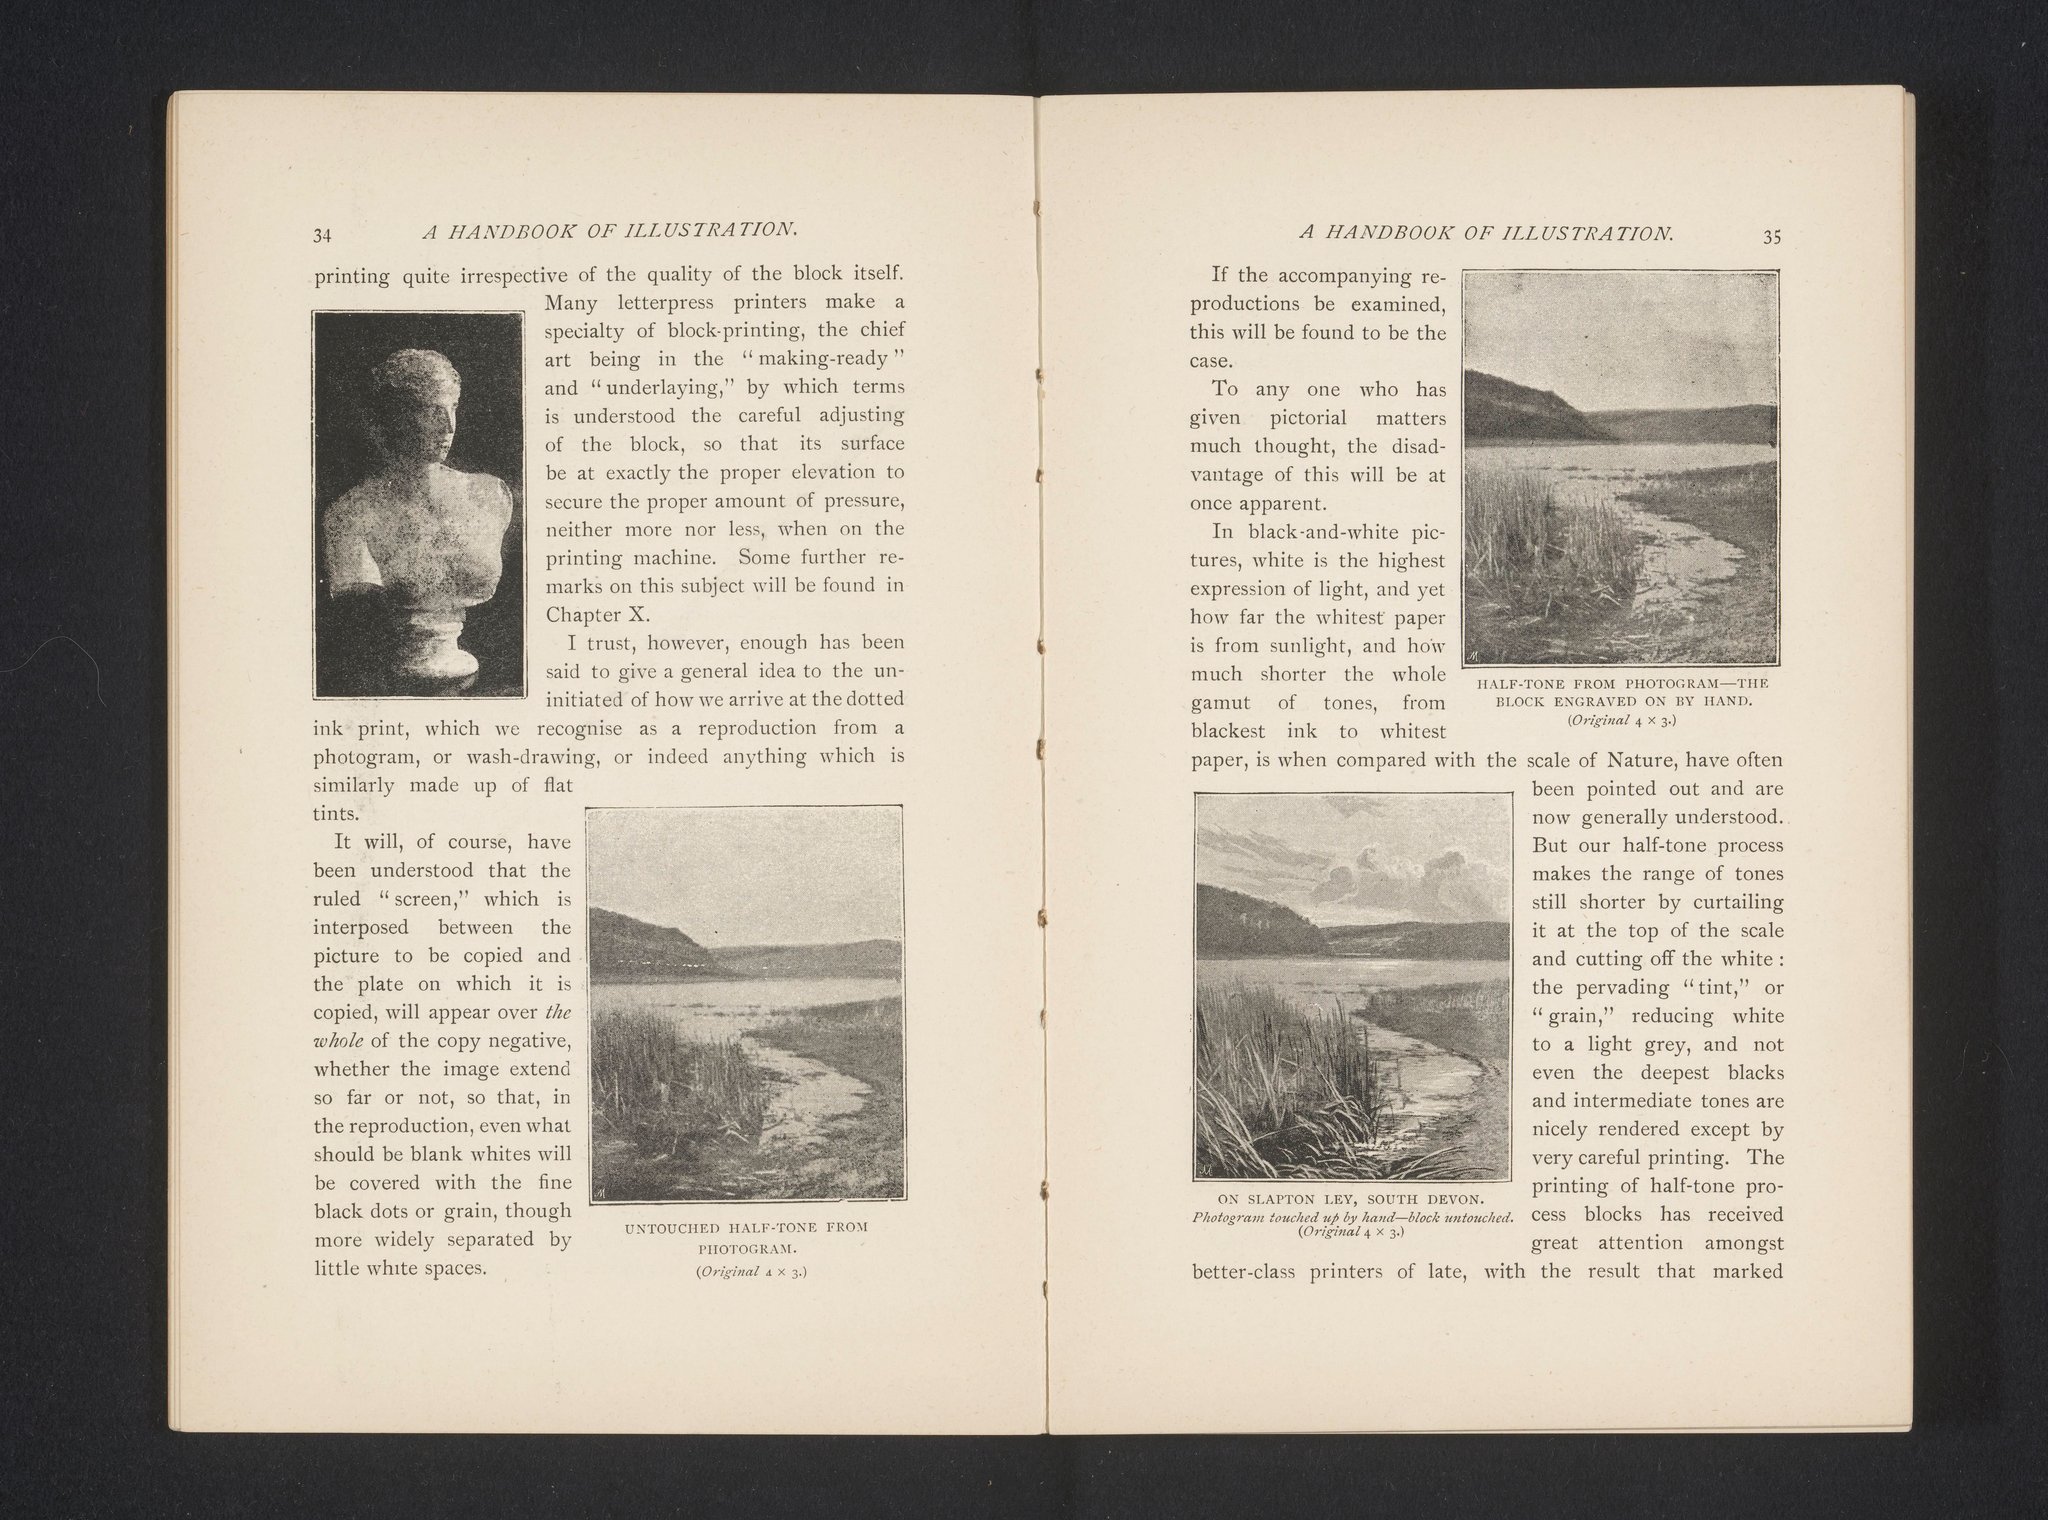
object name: photomechanical print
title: Fotoreproductie van een fotogram van Slapton Ley in Devon en een buste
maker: Anonymous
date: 1898-1908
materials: paper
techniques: autotype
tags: chest, bust, landscapes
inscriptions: inscription: ‘Untouched half-tone from photogram. (Original 4 x 3.)’